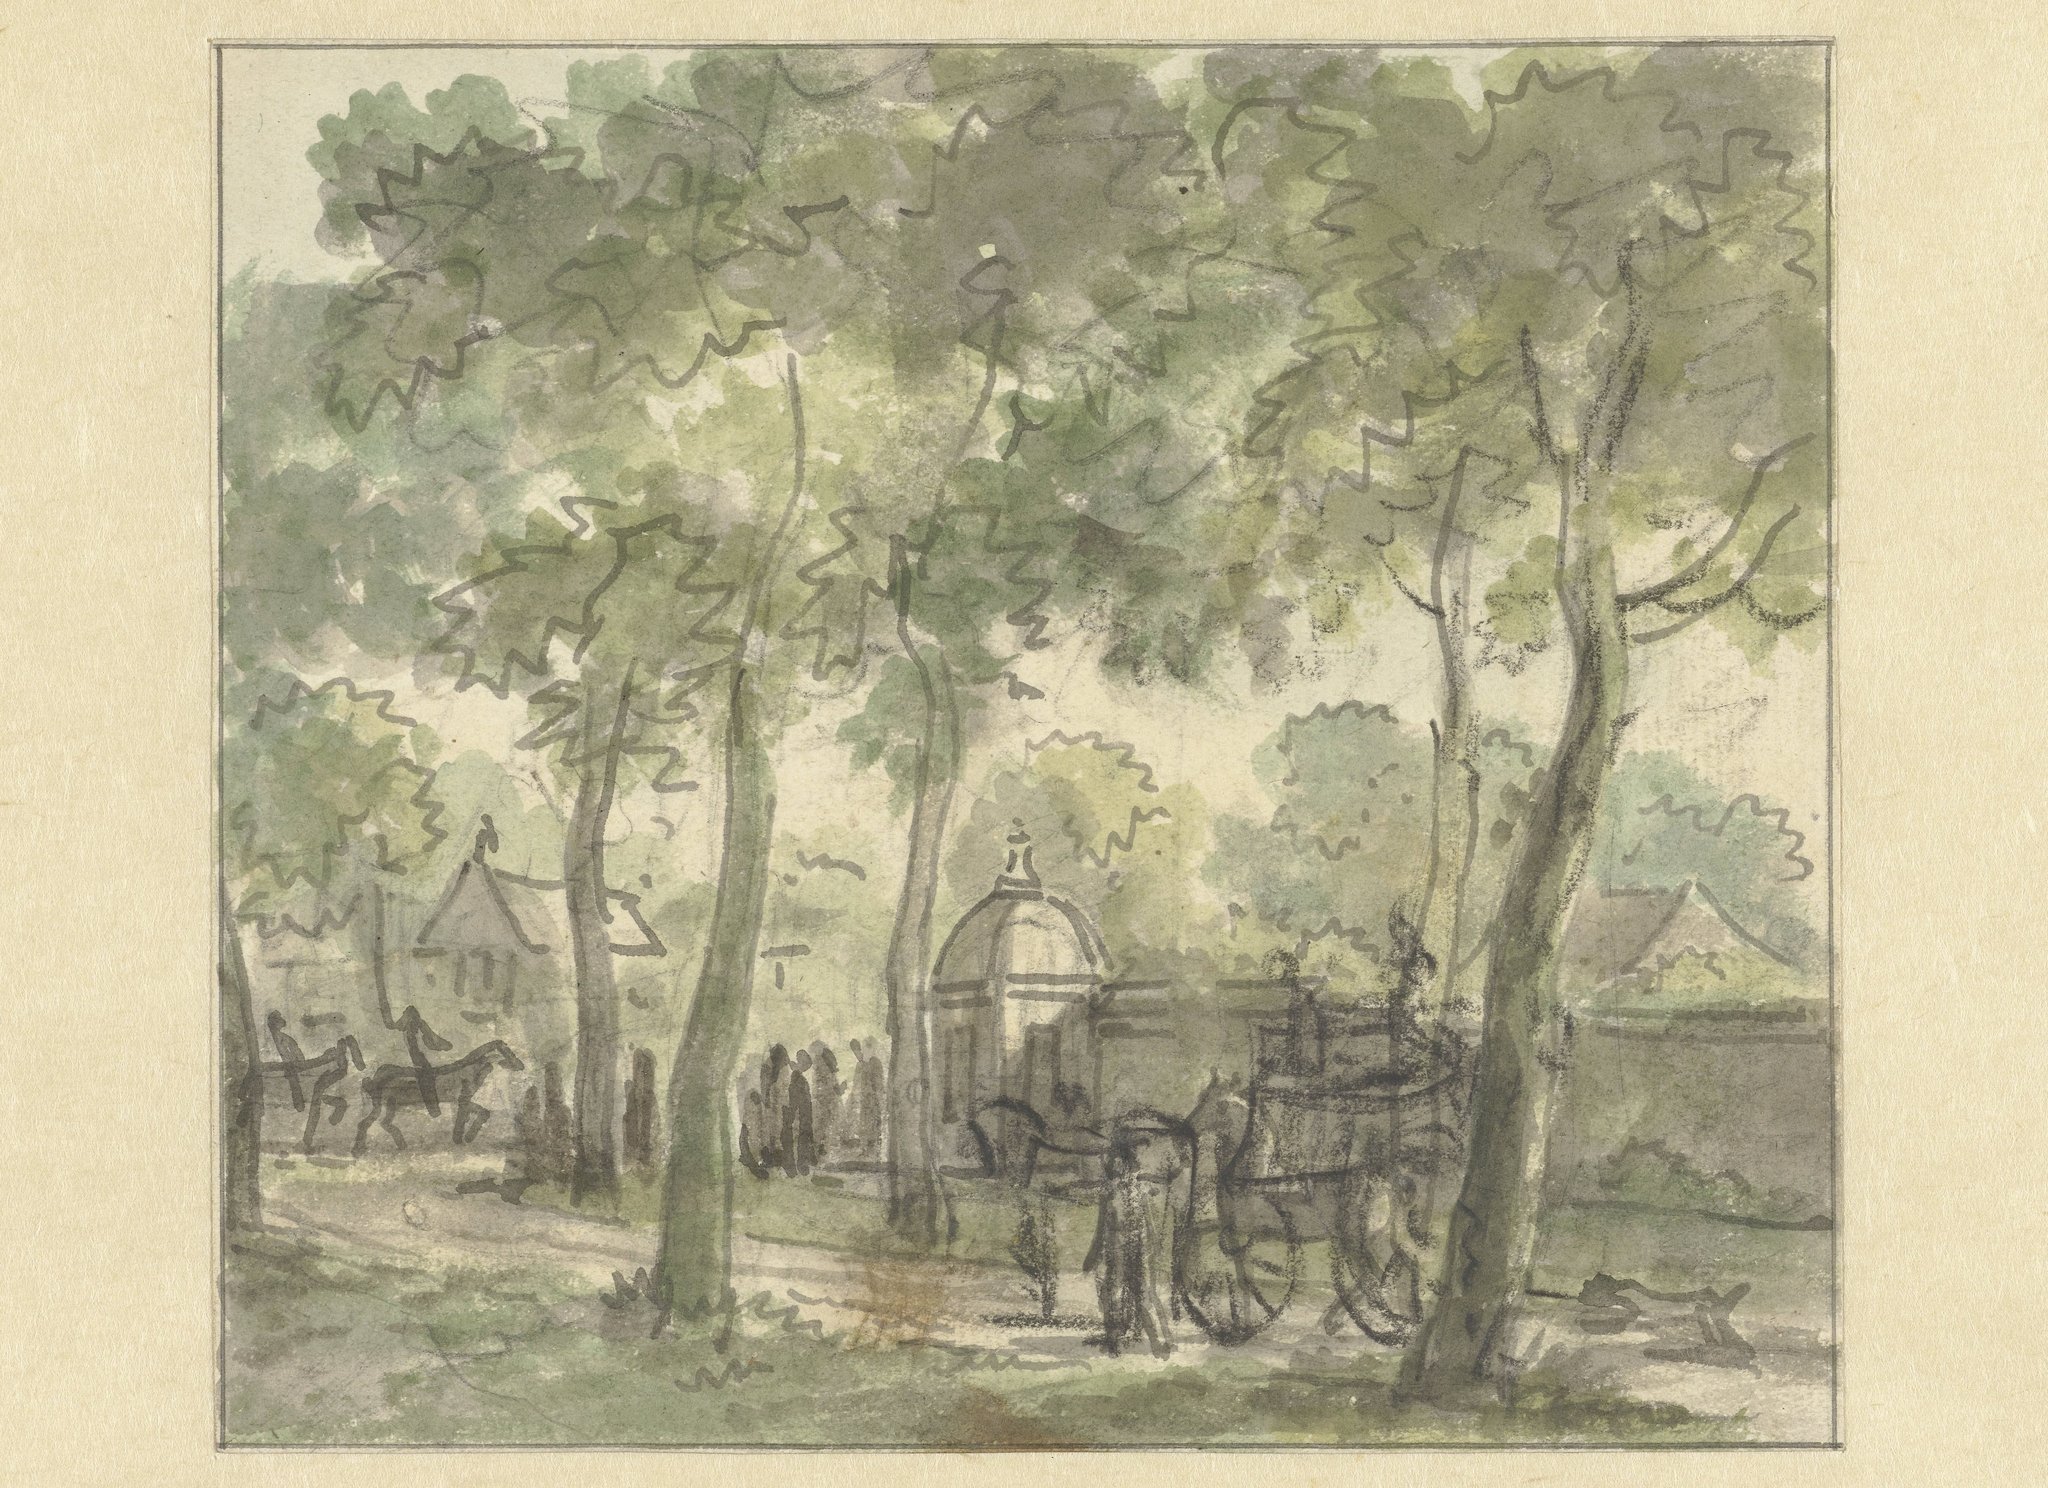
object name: drawing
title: Landweg langs muur met koepel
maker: jurriaan andriessen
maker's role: draughtsman, painter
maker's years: 1742-1819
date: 1752-1819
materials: chalk, ink, paper, watercolor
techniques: brush, pen